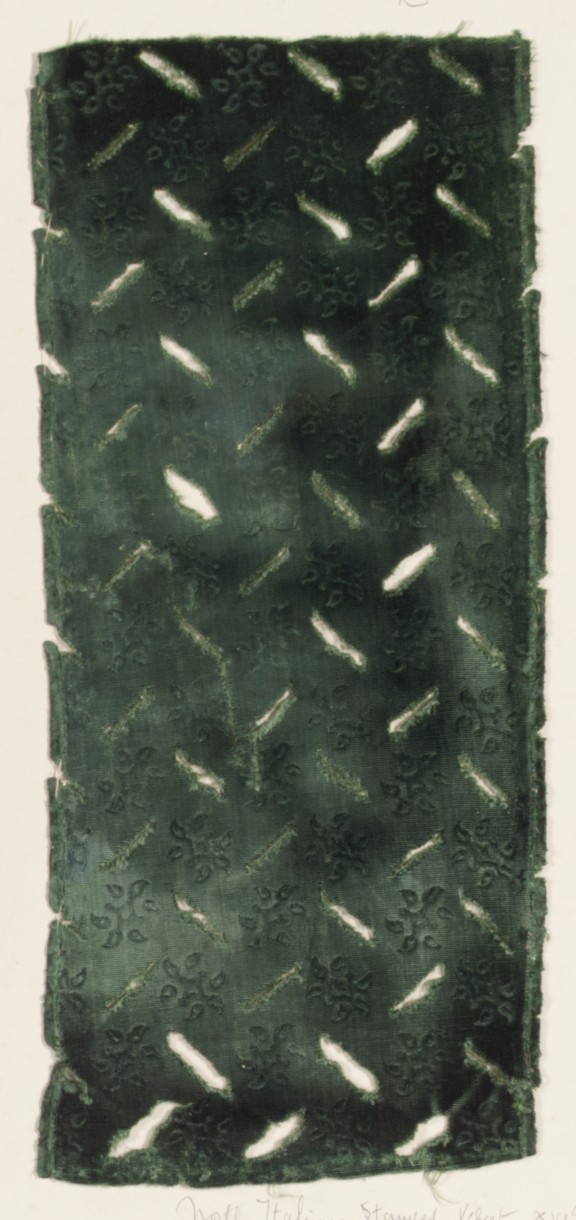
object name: fragment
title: Fragment of stamped velvet with slashing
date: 1501-1600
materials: silk